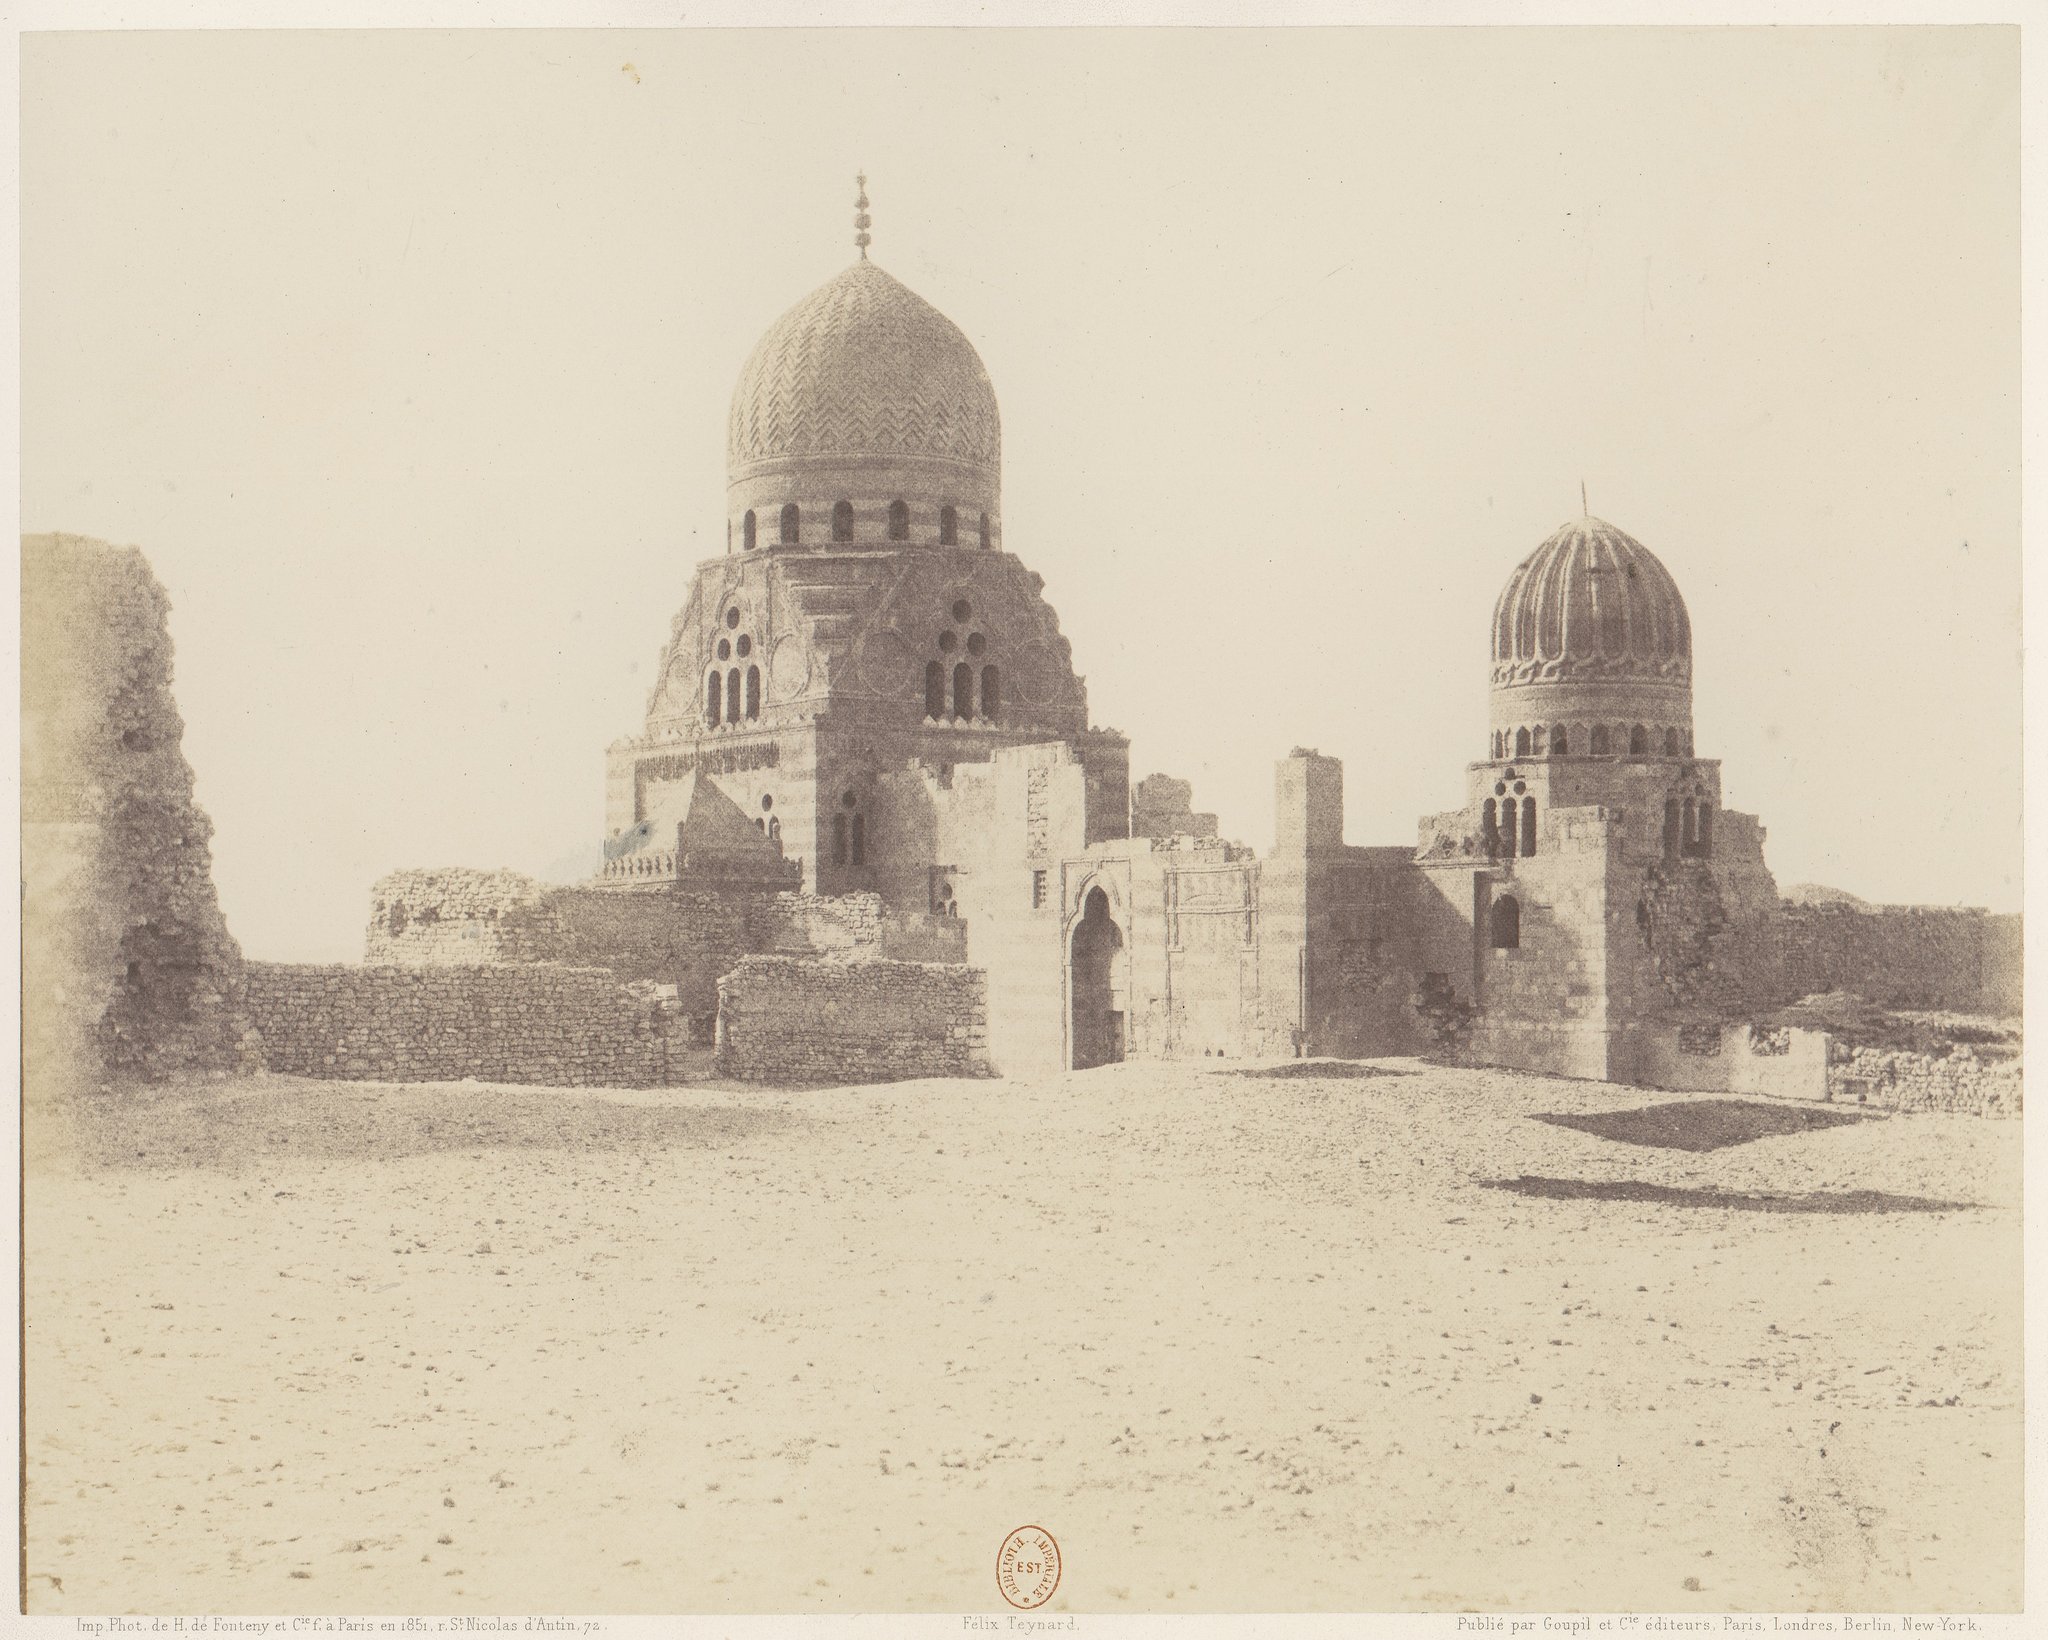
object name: photograph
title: Le Kaire, Tombeaux de Sultans Mamelouks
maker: félix teynard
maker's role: artist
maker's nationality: french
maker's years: 1817-1892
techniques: paper negative, salted paper print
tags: architecture,tombs